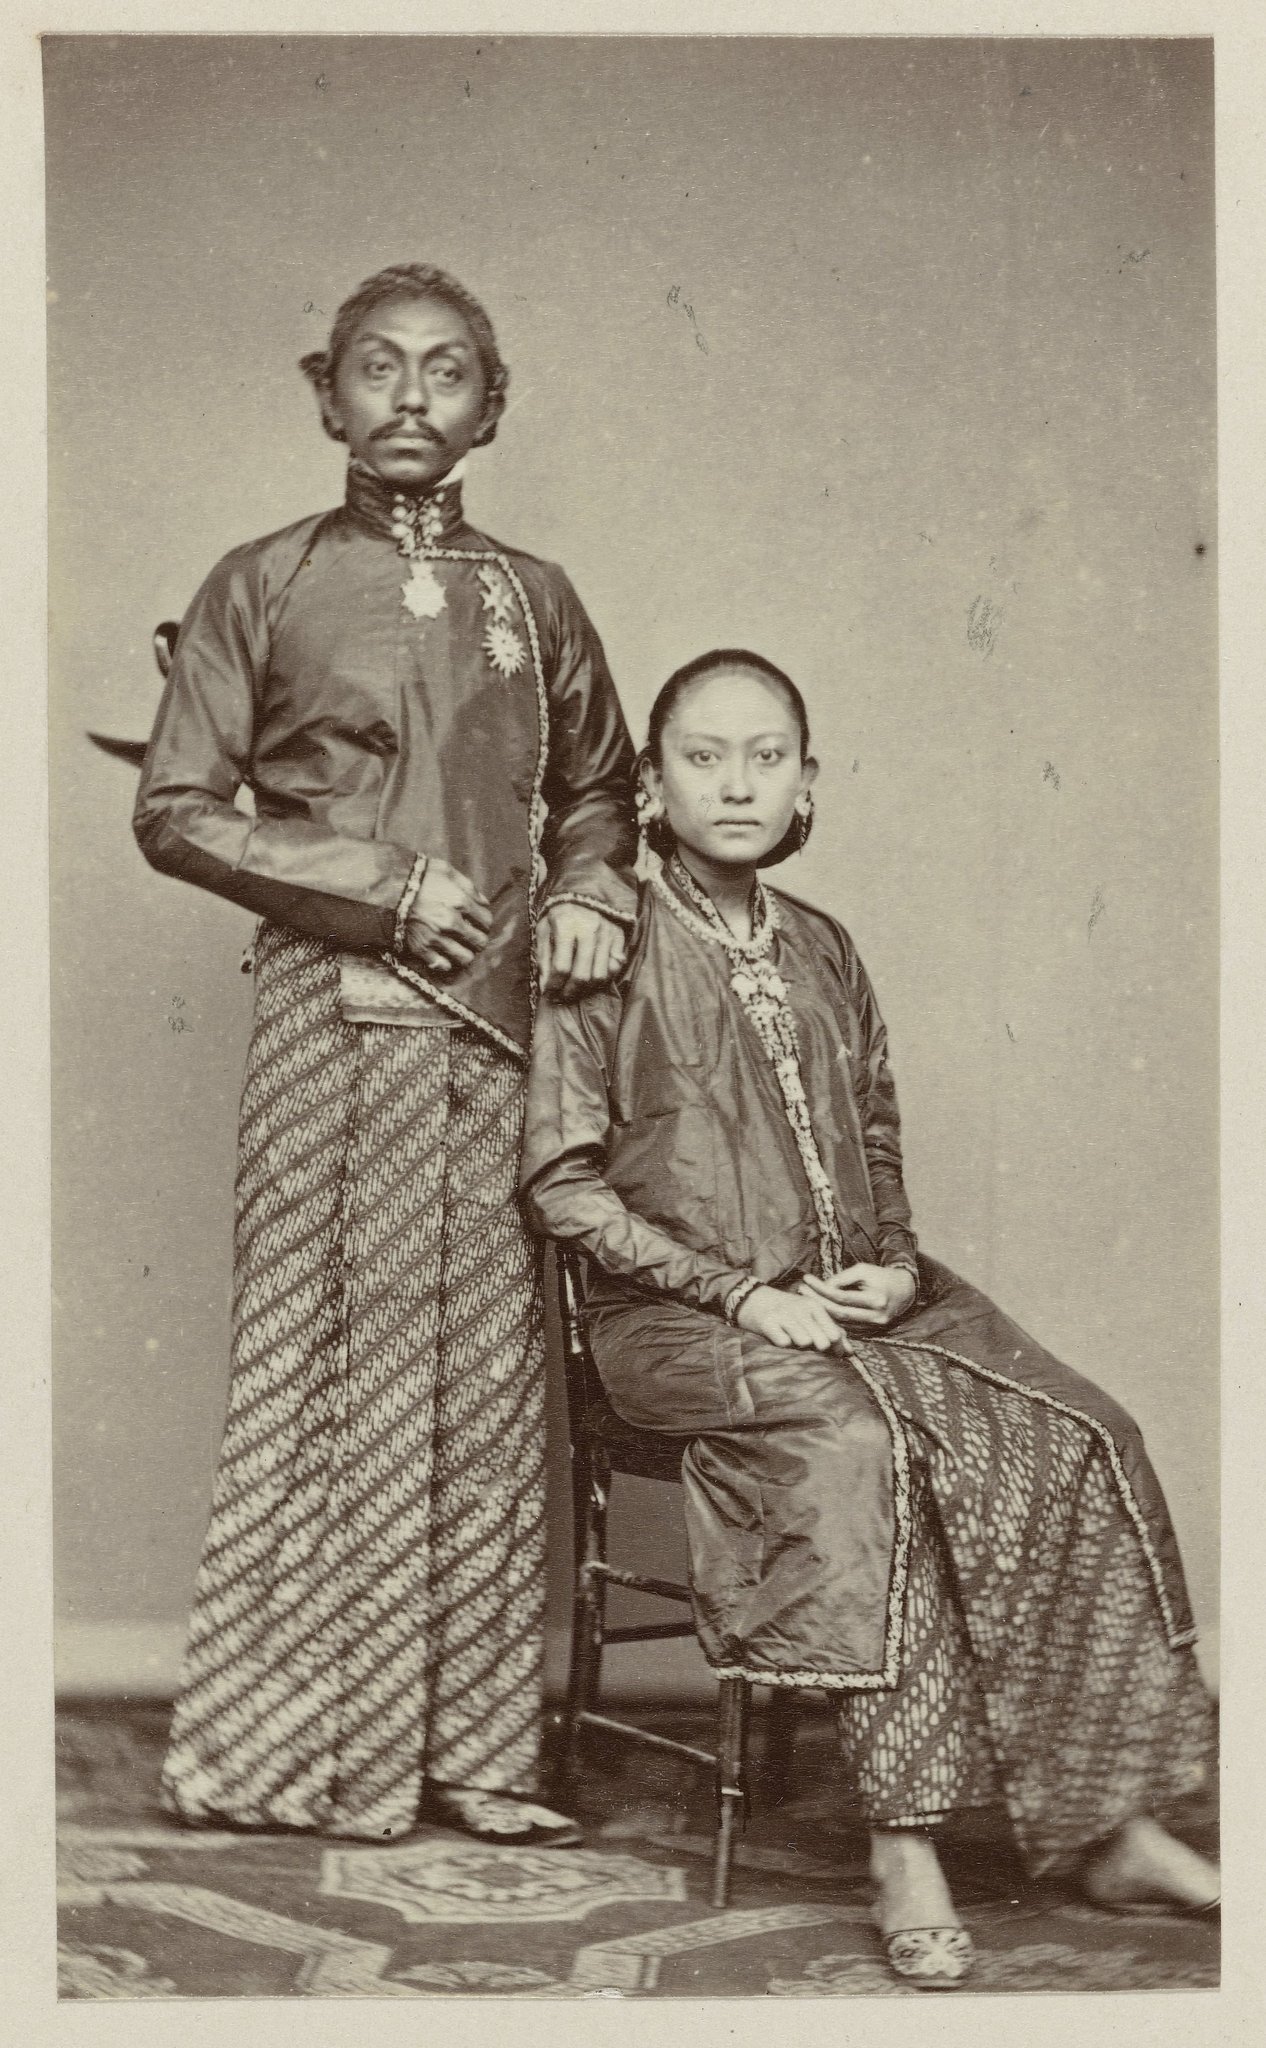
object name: photograph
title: Pakoe Boewono IX, Susuhunan van Surakarta met zijn echtgenote Ratoe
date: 1868-1872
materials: photographic support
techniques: albumen print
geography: batavia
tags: historical persons - bb - woman, historical persons, marriage, married couple, 'matrimonium', java, batavia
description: Studioportret van Pakoe Boewono IX, Susuhunan van Surakarta, met zijn echtgenote Ratoe. Ingeplakte foto in het fotoalbum getiteld: Gezichten van Java.